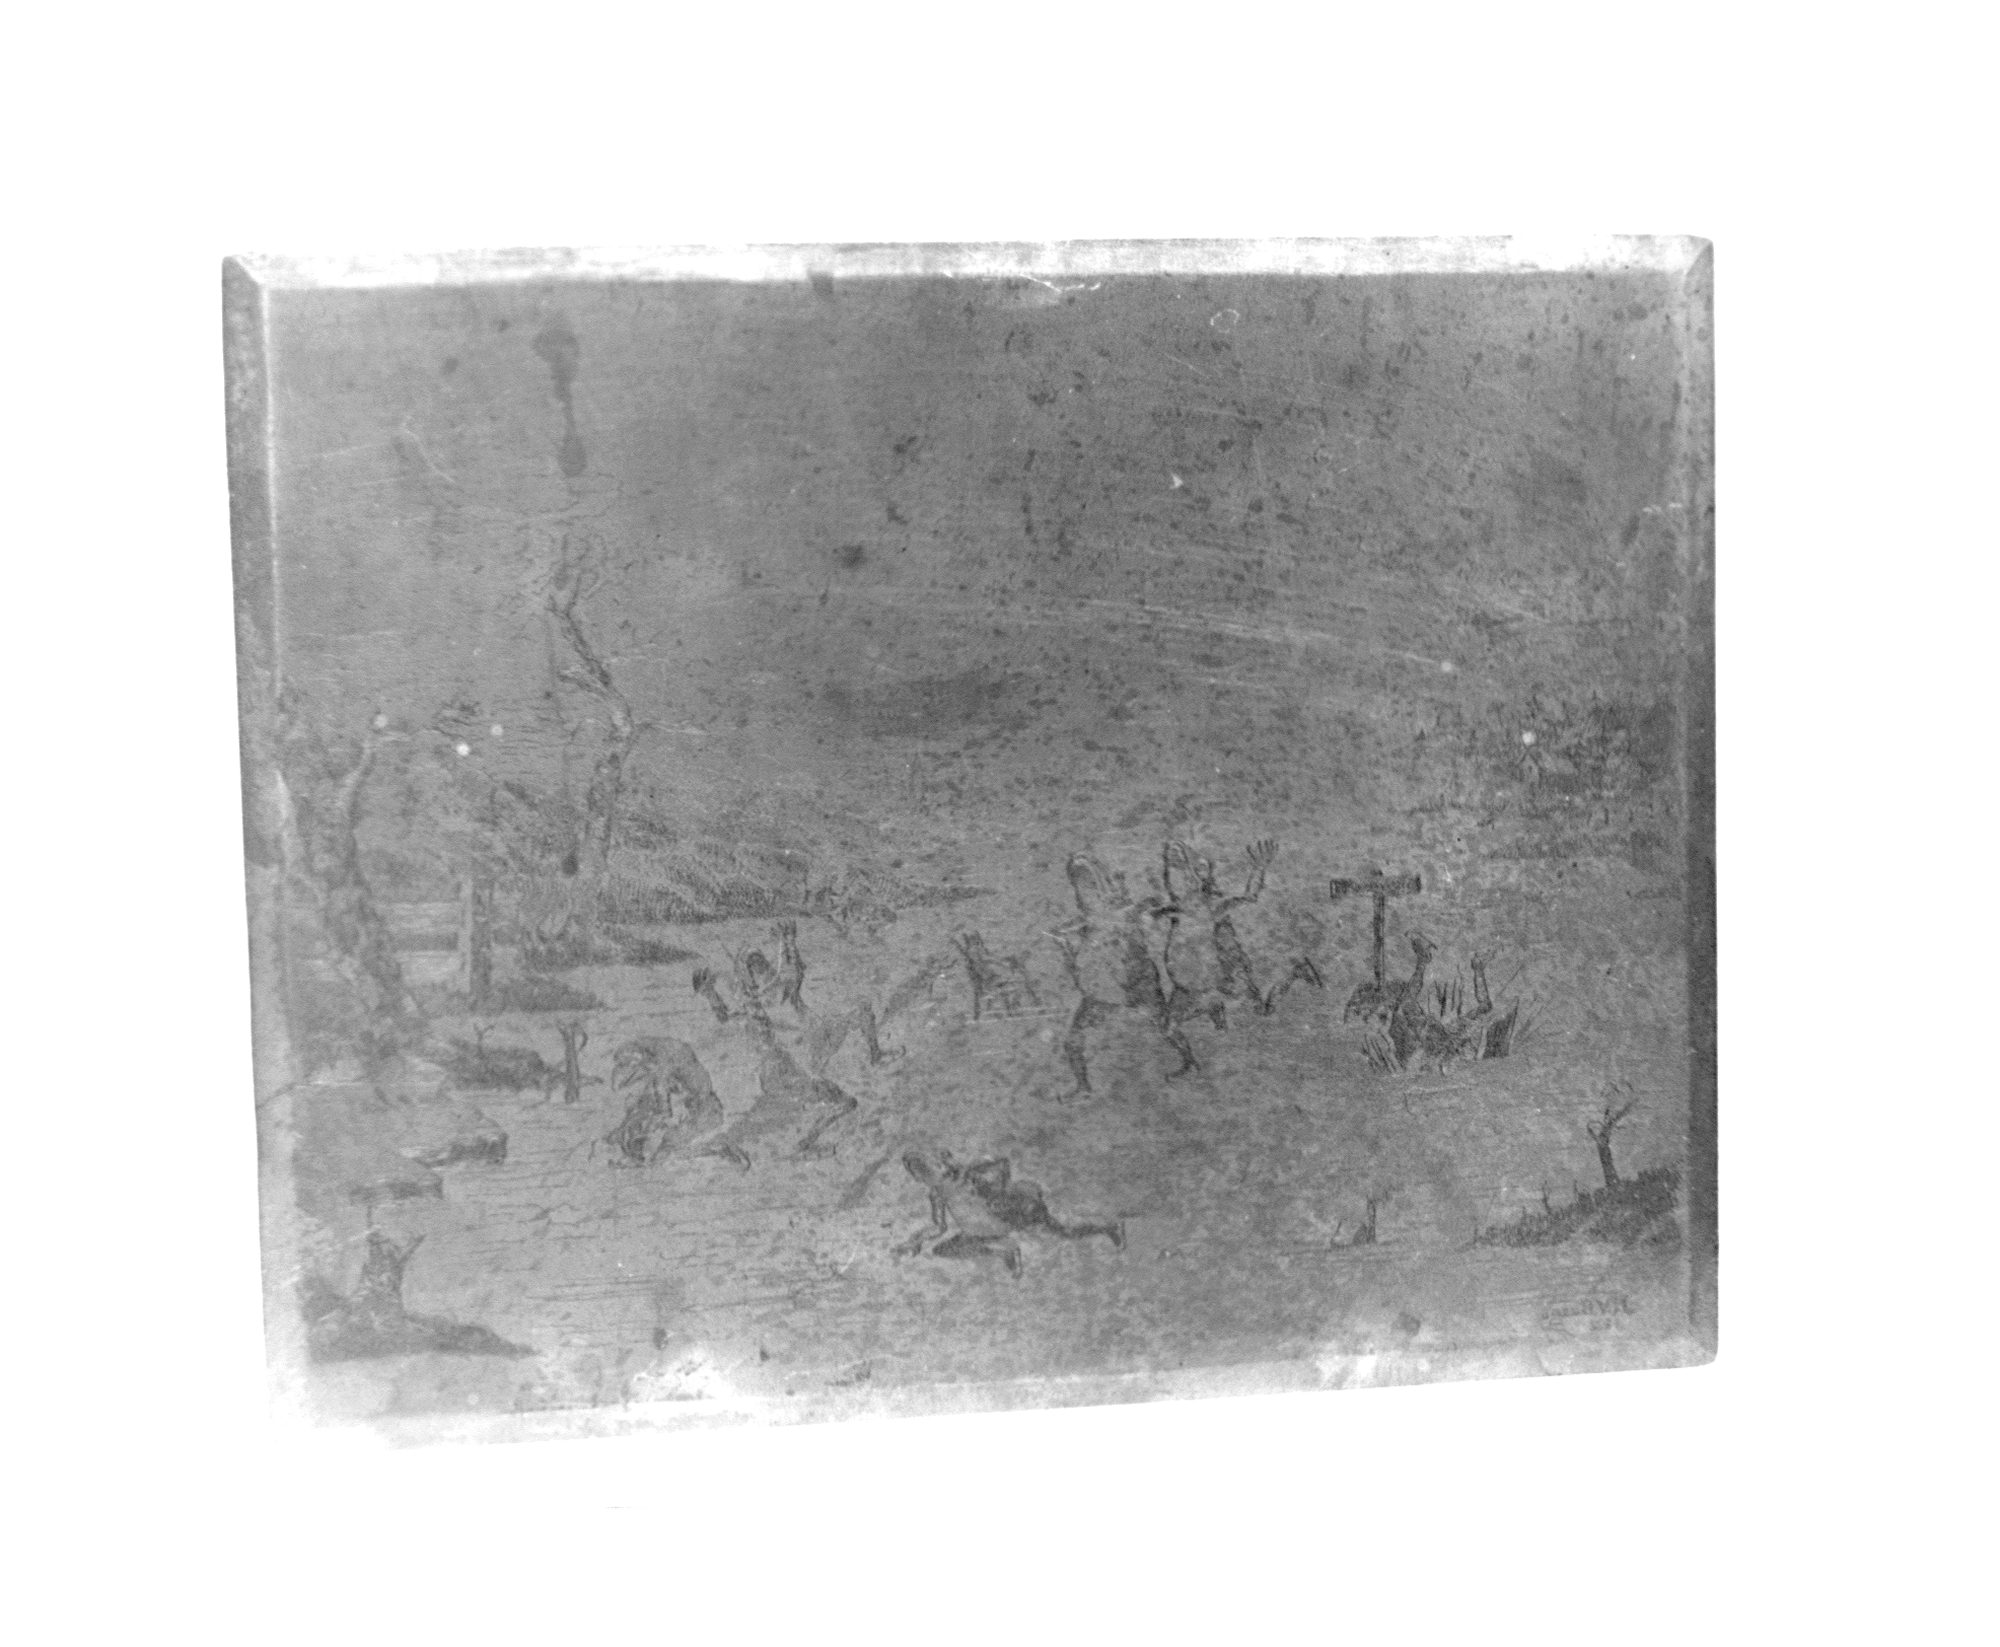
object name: plate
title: Frogs Skating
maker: henry victor burgy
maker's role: artist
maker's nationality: french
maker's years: 1801-1901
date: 1866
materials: copper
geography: france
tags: frogs